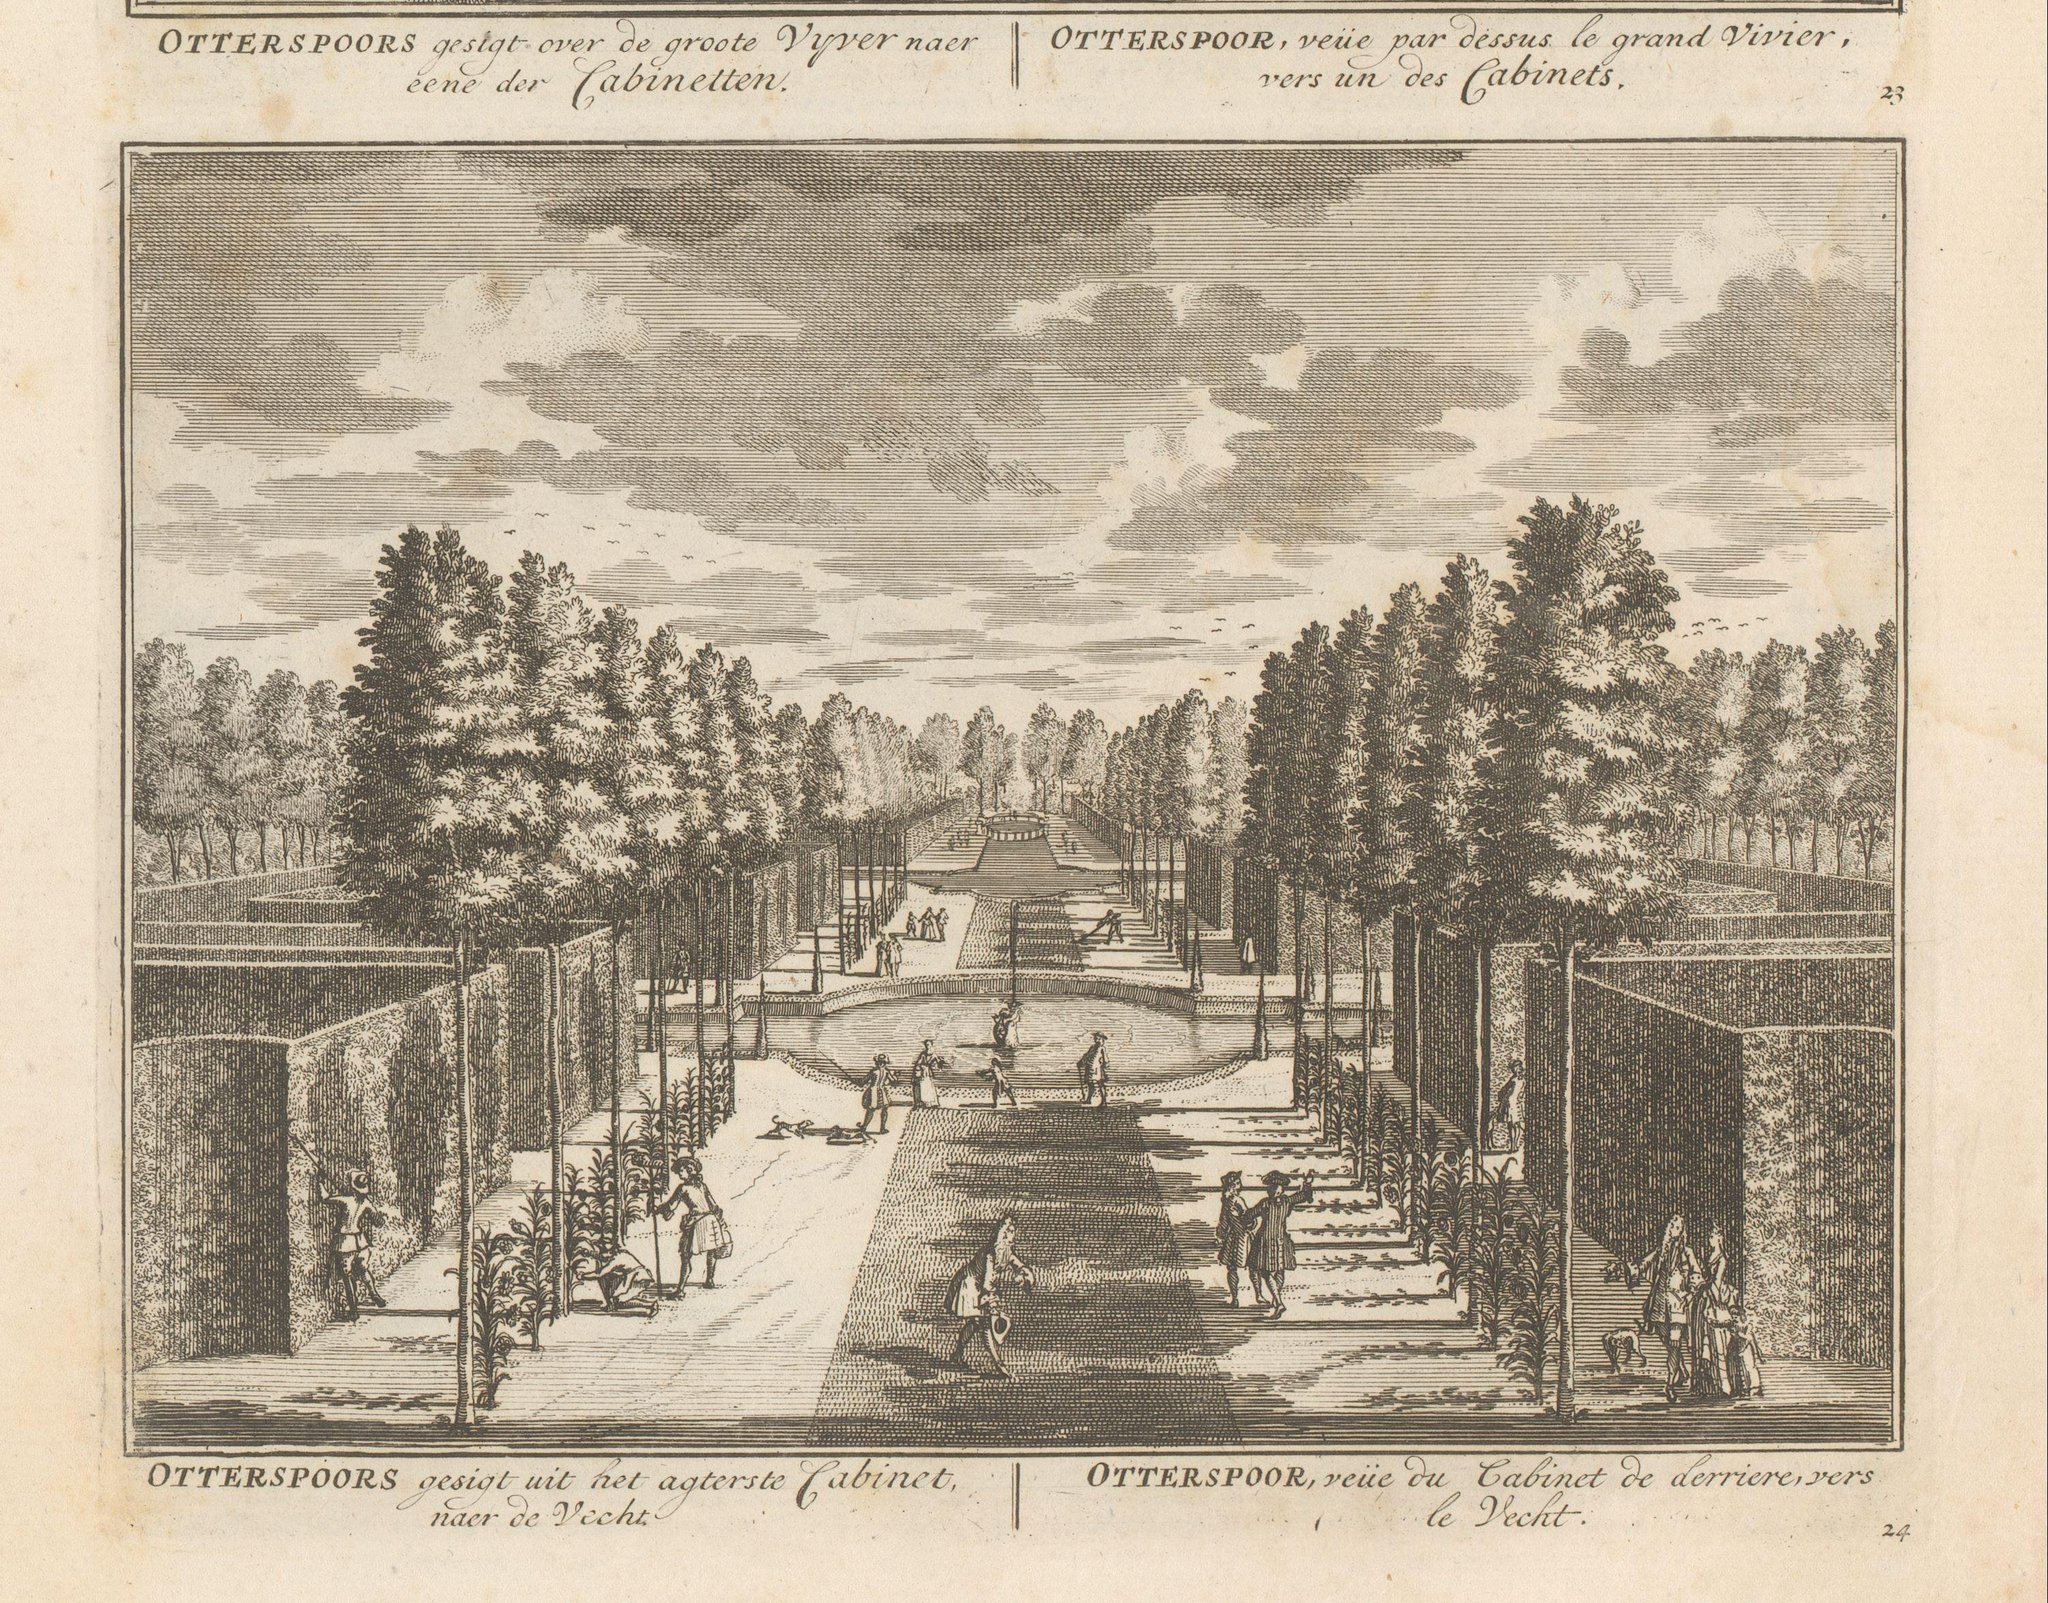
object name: book illustration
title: Otterspoors gesigt uit het agterste Cabinet, naer de Vecht / Otterspoor, veiie du Cabinet de derriere, vers le Vecht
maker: daniël stopendaal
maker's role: print maker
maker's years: 1672-1726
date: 1790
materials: paper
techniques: engraving, etching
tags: country-house, maarssen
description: Prent gebruikt in: Leth, Andries de. De zegepraalende Vecht, vertoonende verscheidene gesichten van lustplaatsen, heeren huysen en dorpen, beginnende van Uitrecht en met Muyden besluytende (...). Amsterdam: Weduwe Nicolaus Visscher, 1719. Prent ook gebruikt in: Brouërius van Nidek, Matthaeus. De Vechtstroom, van Utrecht tot Muiden (...). Amsterdam: H. Gartman, W. Vermandel en J.W. Smit, 1790.